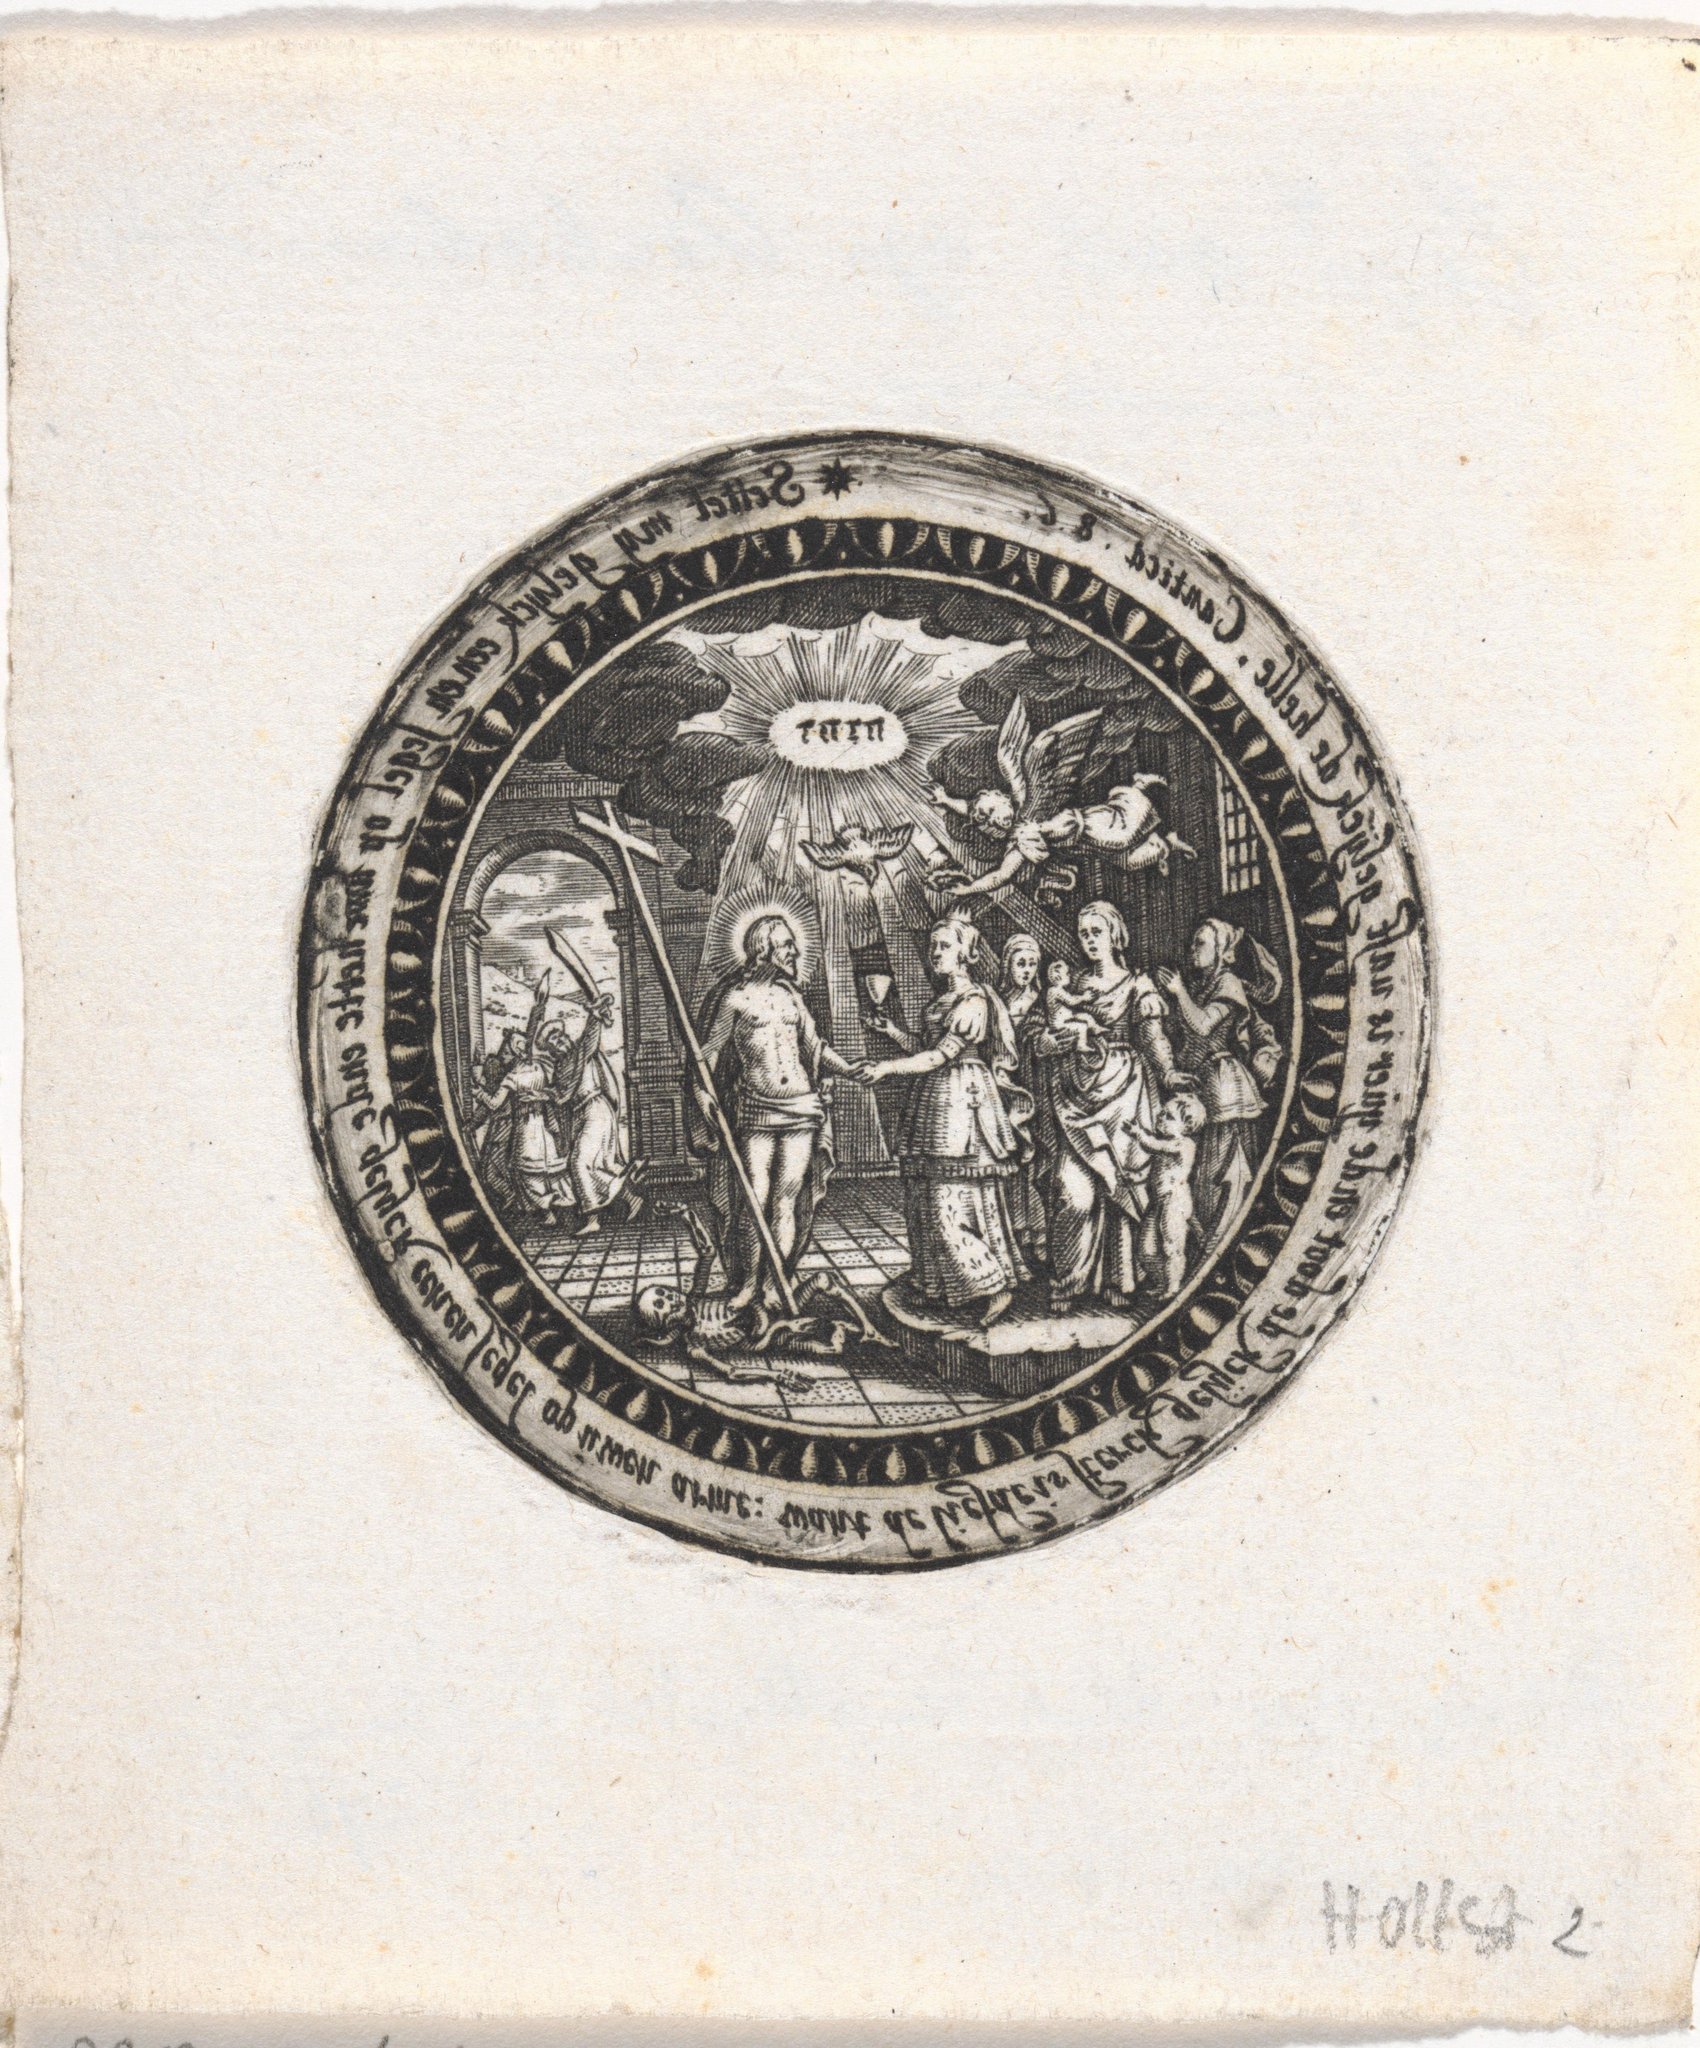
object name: print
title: Afdruk van een medaillon met een voorstelling van het huwelijk van Christus met zijn kerk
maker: dirck strijcker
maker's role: draughtsman, print maker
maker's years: 1588-1677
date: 1607-1677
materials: paper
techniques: printmaking, engraving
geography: amsterdam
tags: 'ecclesia' as bride of christ (the lamb), 'ecclesia sponsa dei', 'sponsus-sponsa', the three theological virtues, tetragram (in roman or hebrew script) ~ symbol of god the father, holy ghost represented as a dove (in flames)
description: Afdruk van een medaillon. Voorstelling van het huwelijk tussen Christus en de Kerk (Ecclesia). Boven hun hoofde de duif van de Heilige Geest en het tetragram als symbool van God de Vader. Ecclesia houdt een kelk in haar hand en achter haar staan Geloof, Hoop en Liefde. Christus houdt het kruis in zijn hand en staat op een geraamte ten teken van zijn overwinning op de dood. In het randschrift een Bijbelvers in spiegelbeeld uit Hoogl. 8:6.